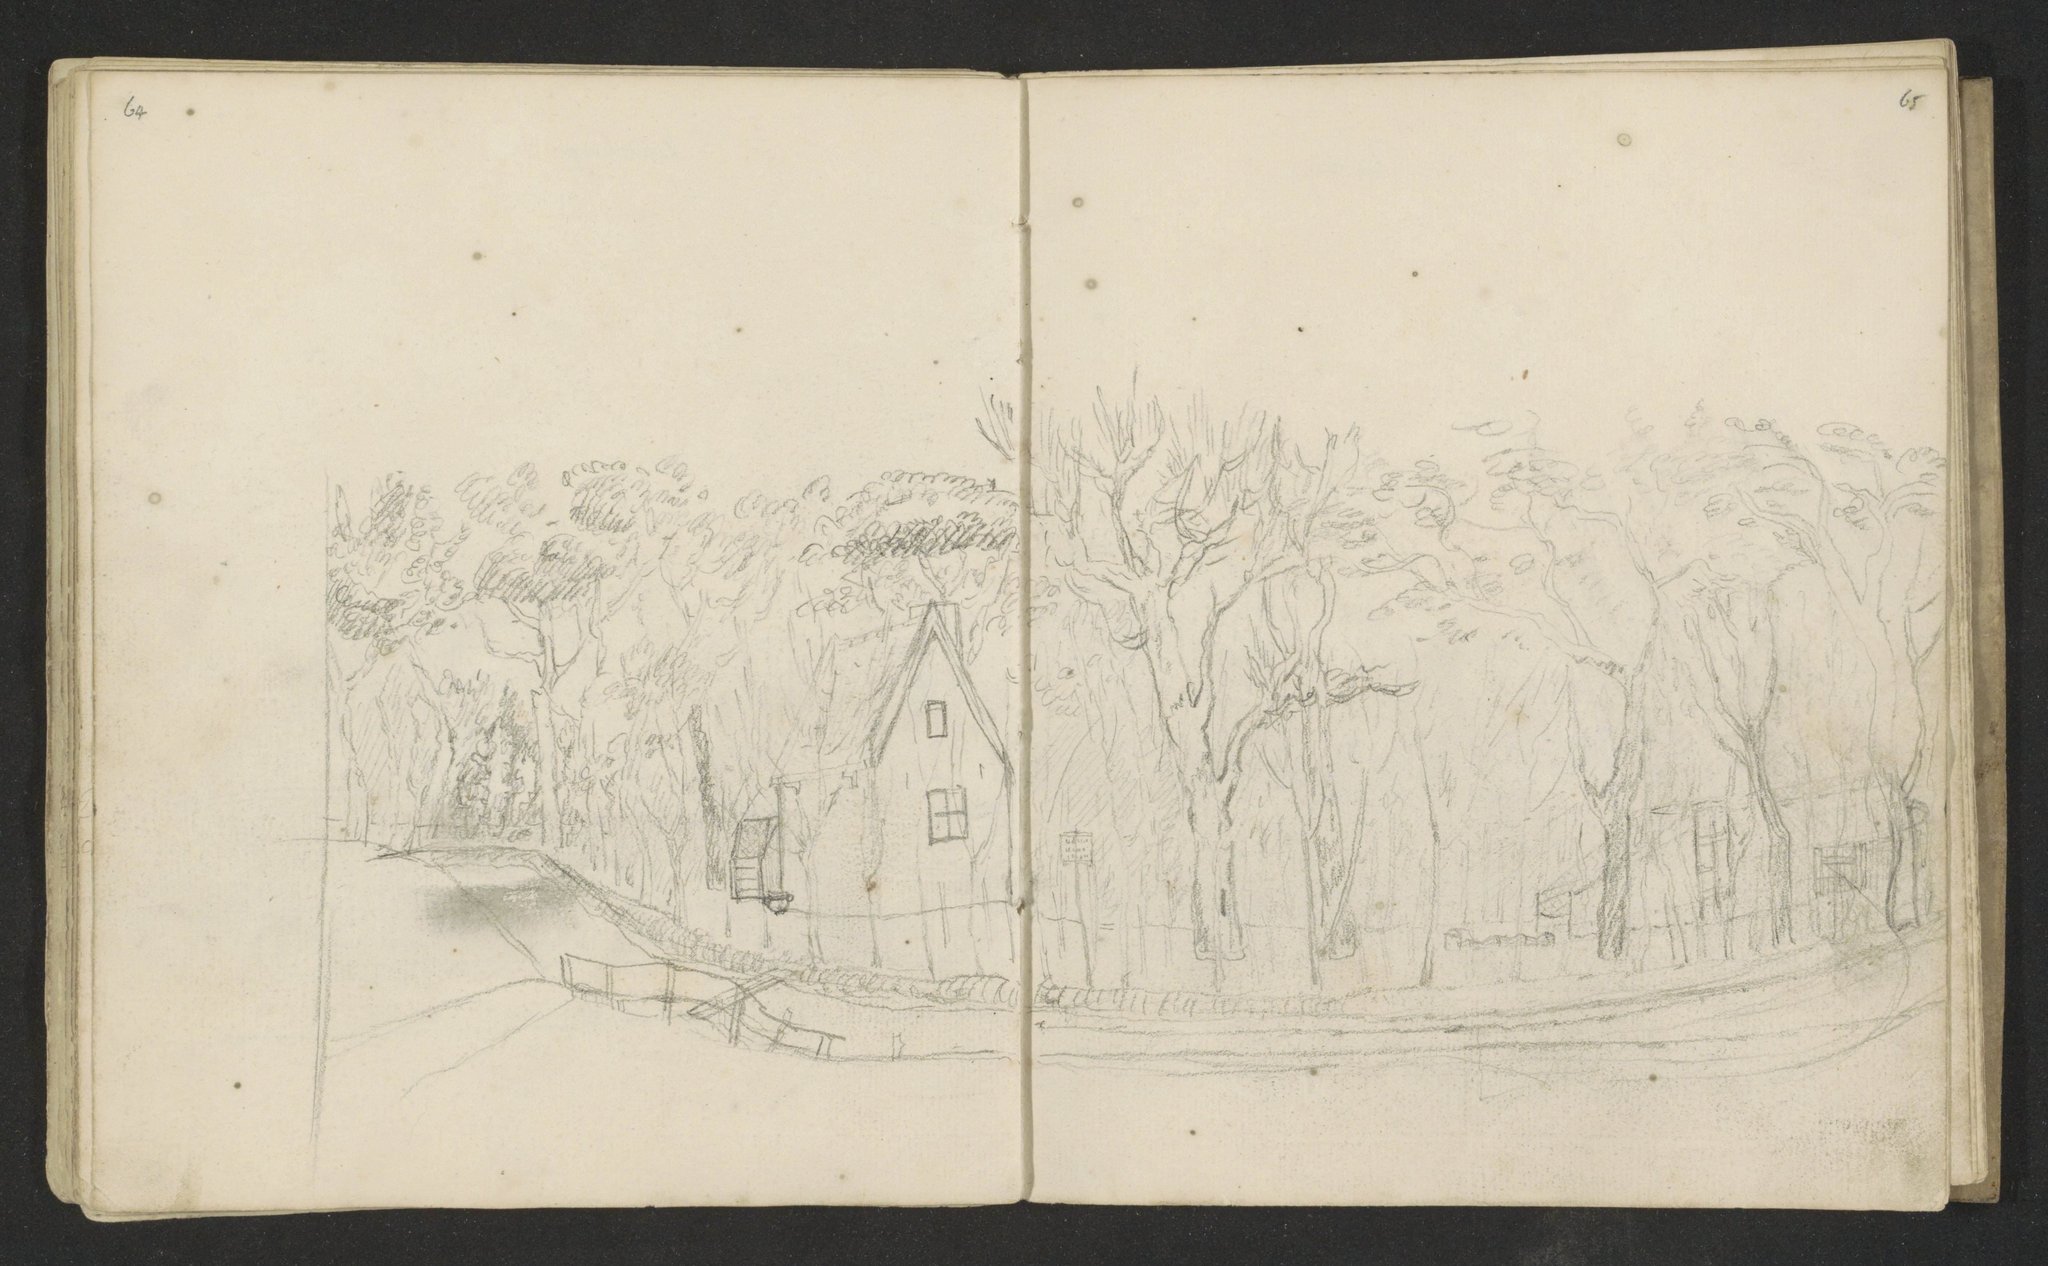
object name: sketchbook leaf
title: Huis gelegen bij een bosrand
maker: Anonymous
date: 1840-1860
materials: paper, pencil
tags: farm or solitary house in landscape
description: Bladzijde 64 en 65 uit een schetsboek met 96 bladzijden.